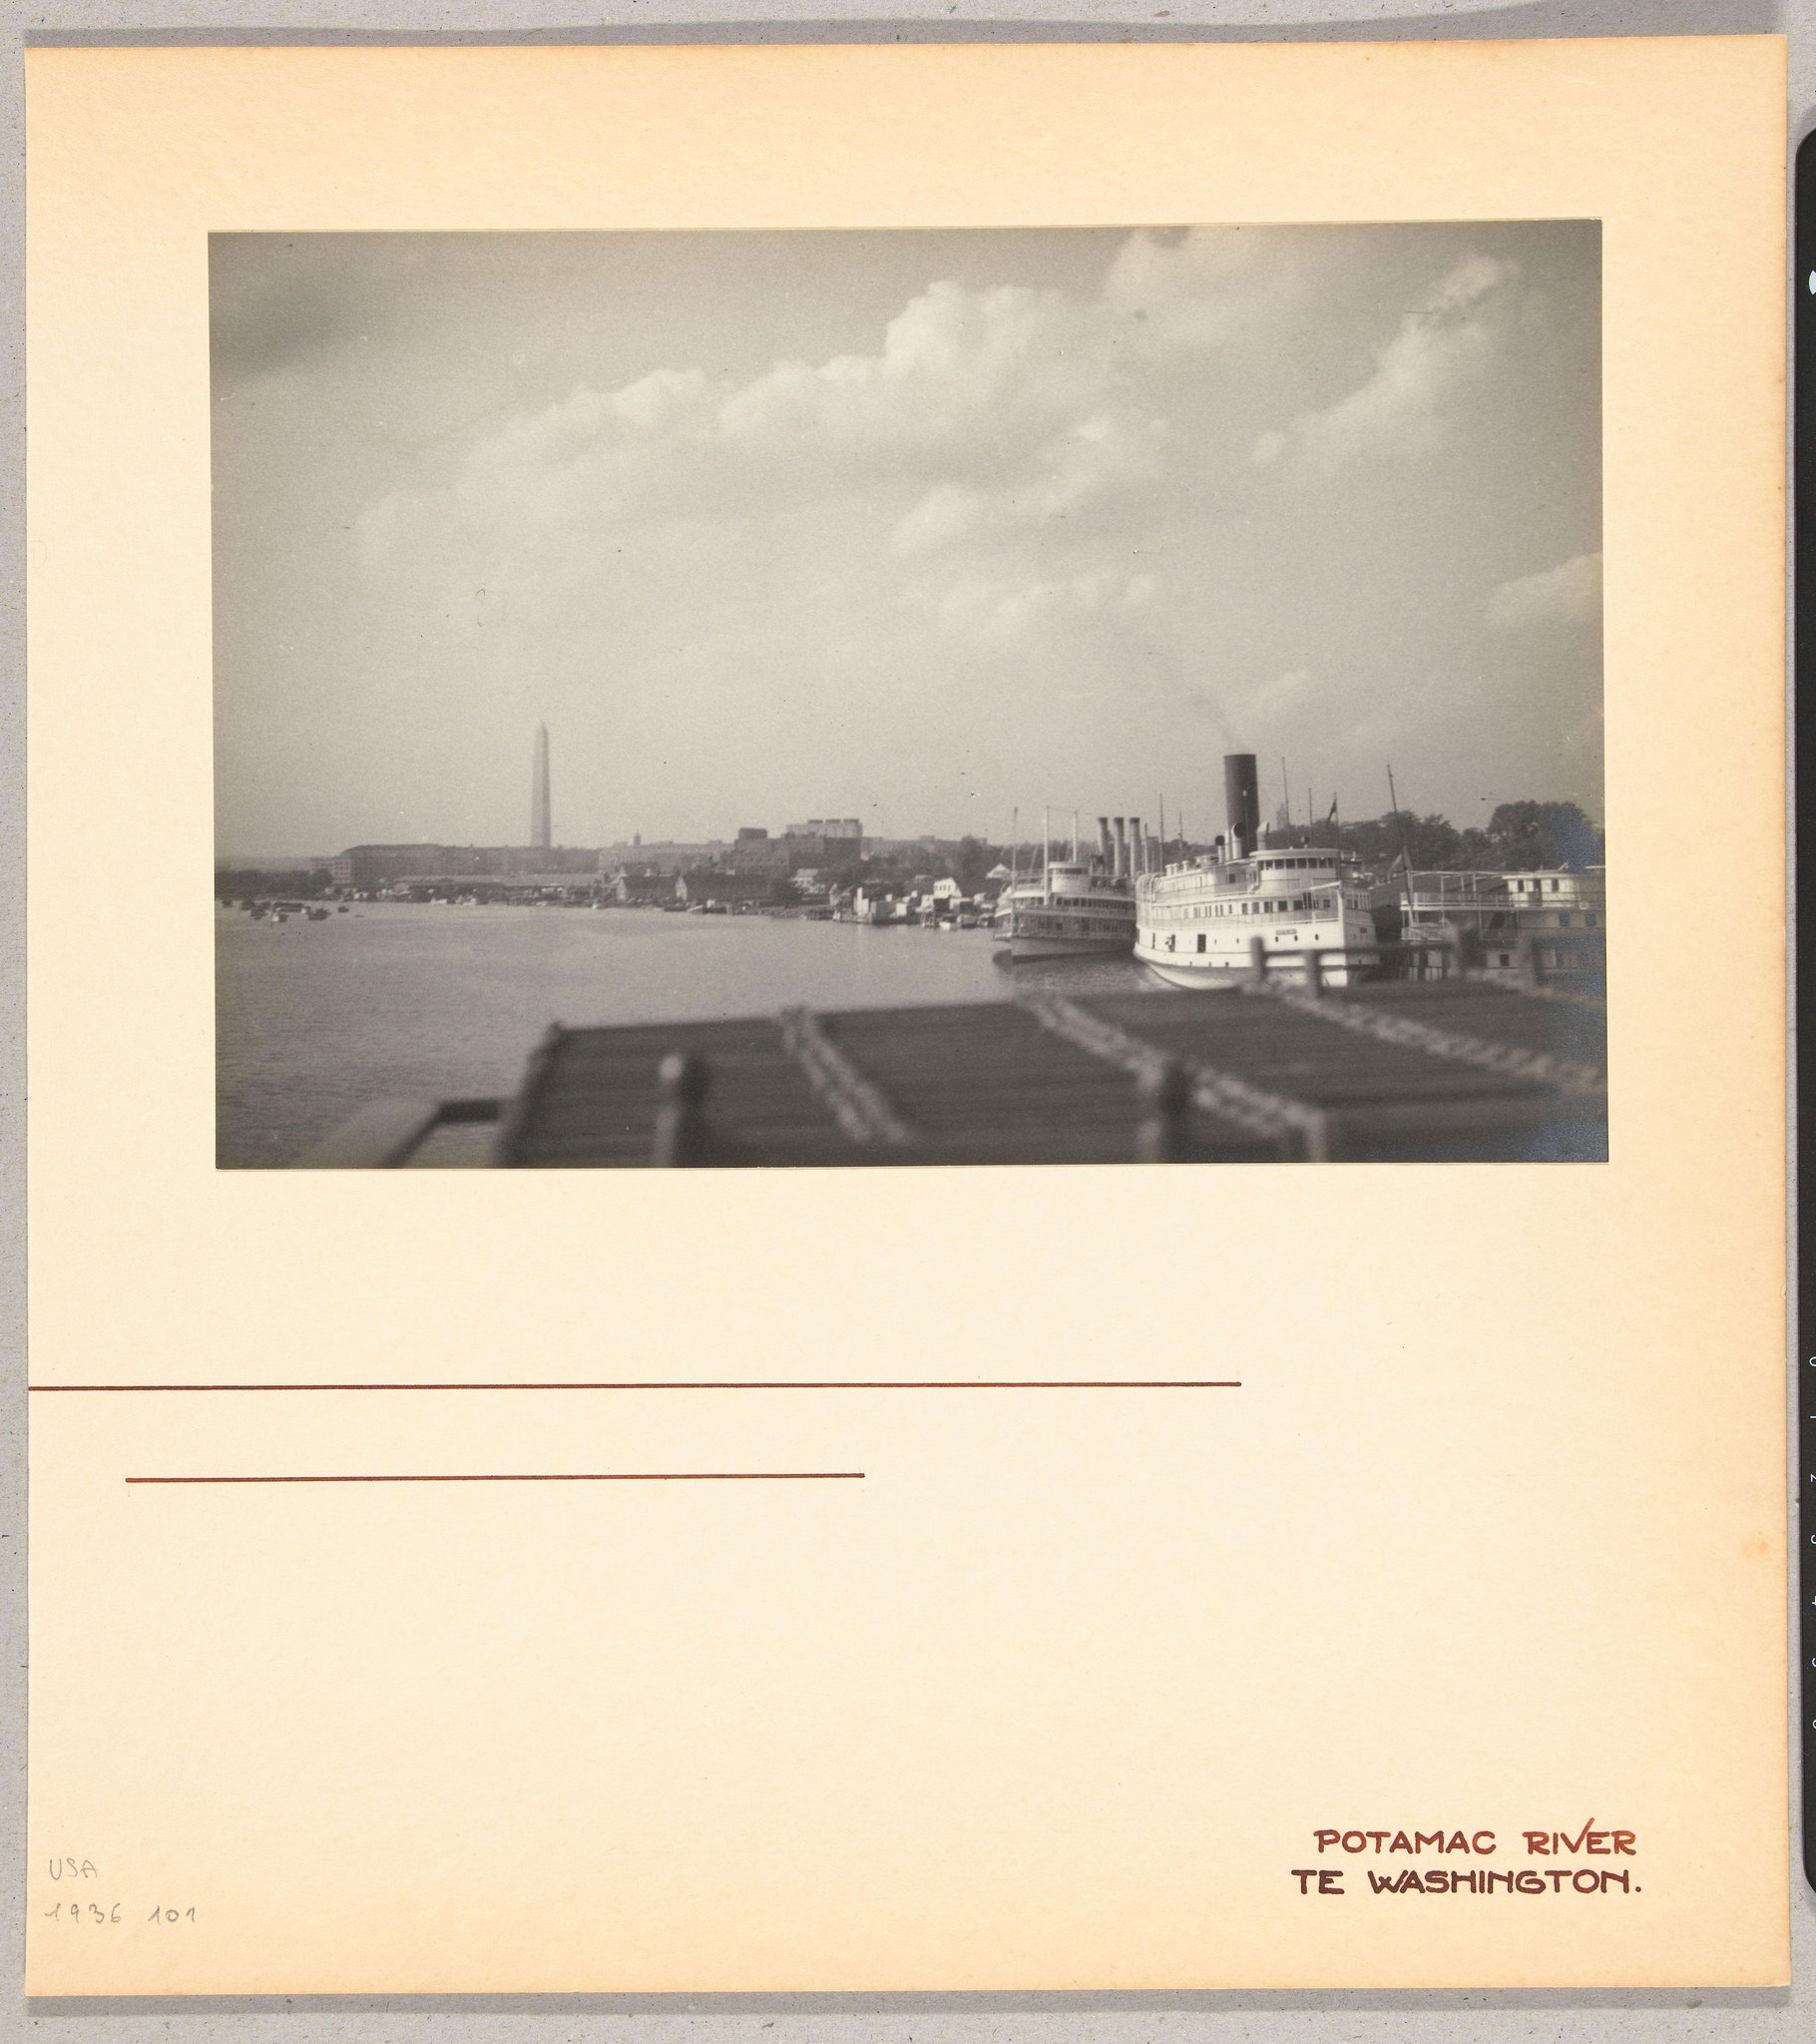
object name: photograph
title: Potomac River, Washington DC, Verenigde Staten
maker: wouter cool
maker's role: engineer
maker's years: 1877-1947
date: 1936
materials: cardboard, paper, photographic support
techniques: gelatin silver print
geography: united states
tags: river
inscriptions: title: ‘POTOMAC RIVER / TE WASHINGTON.’